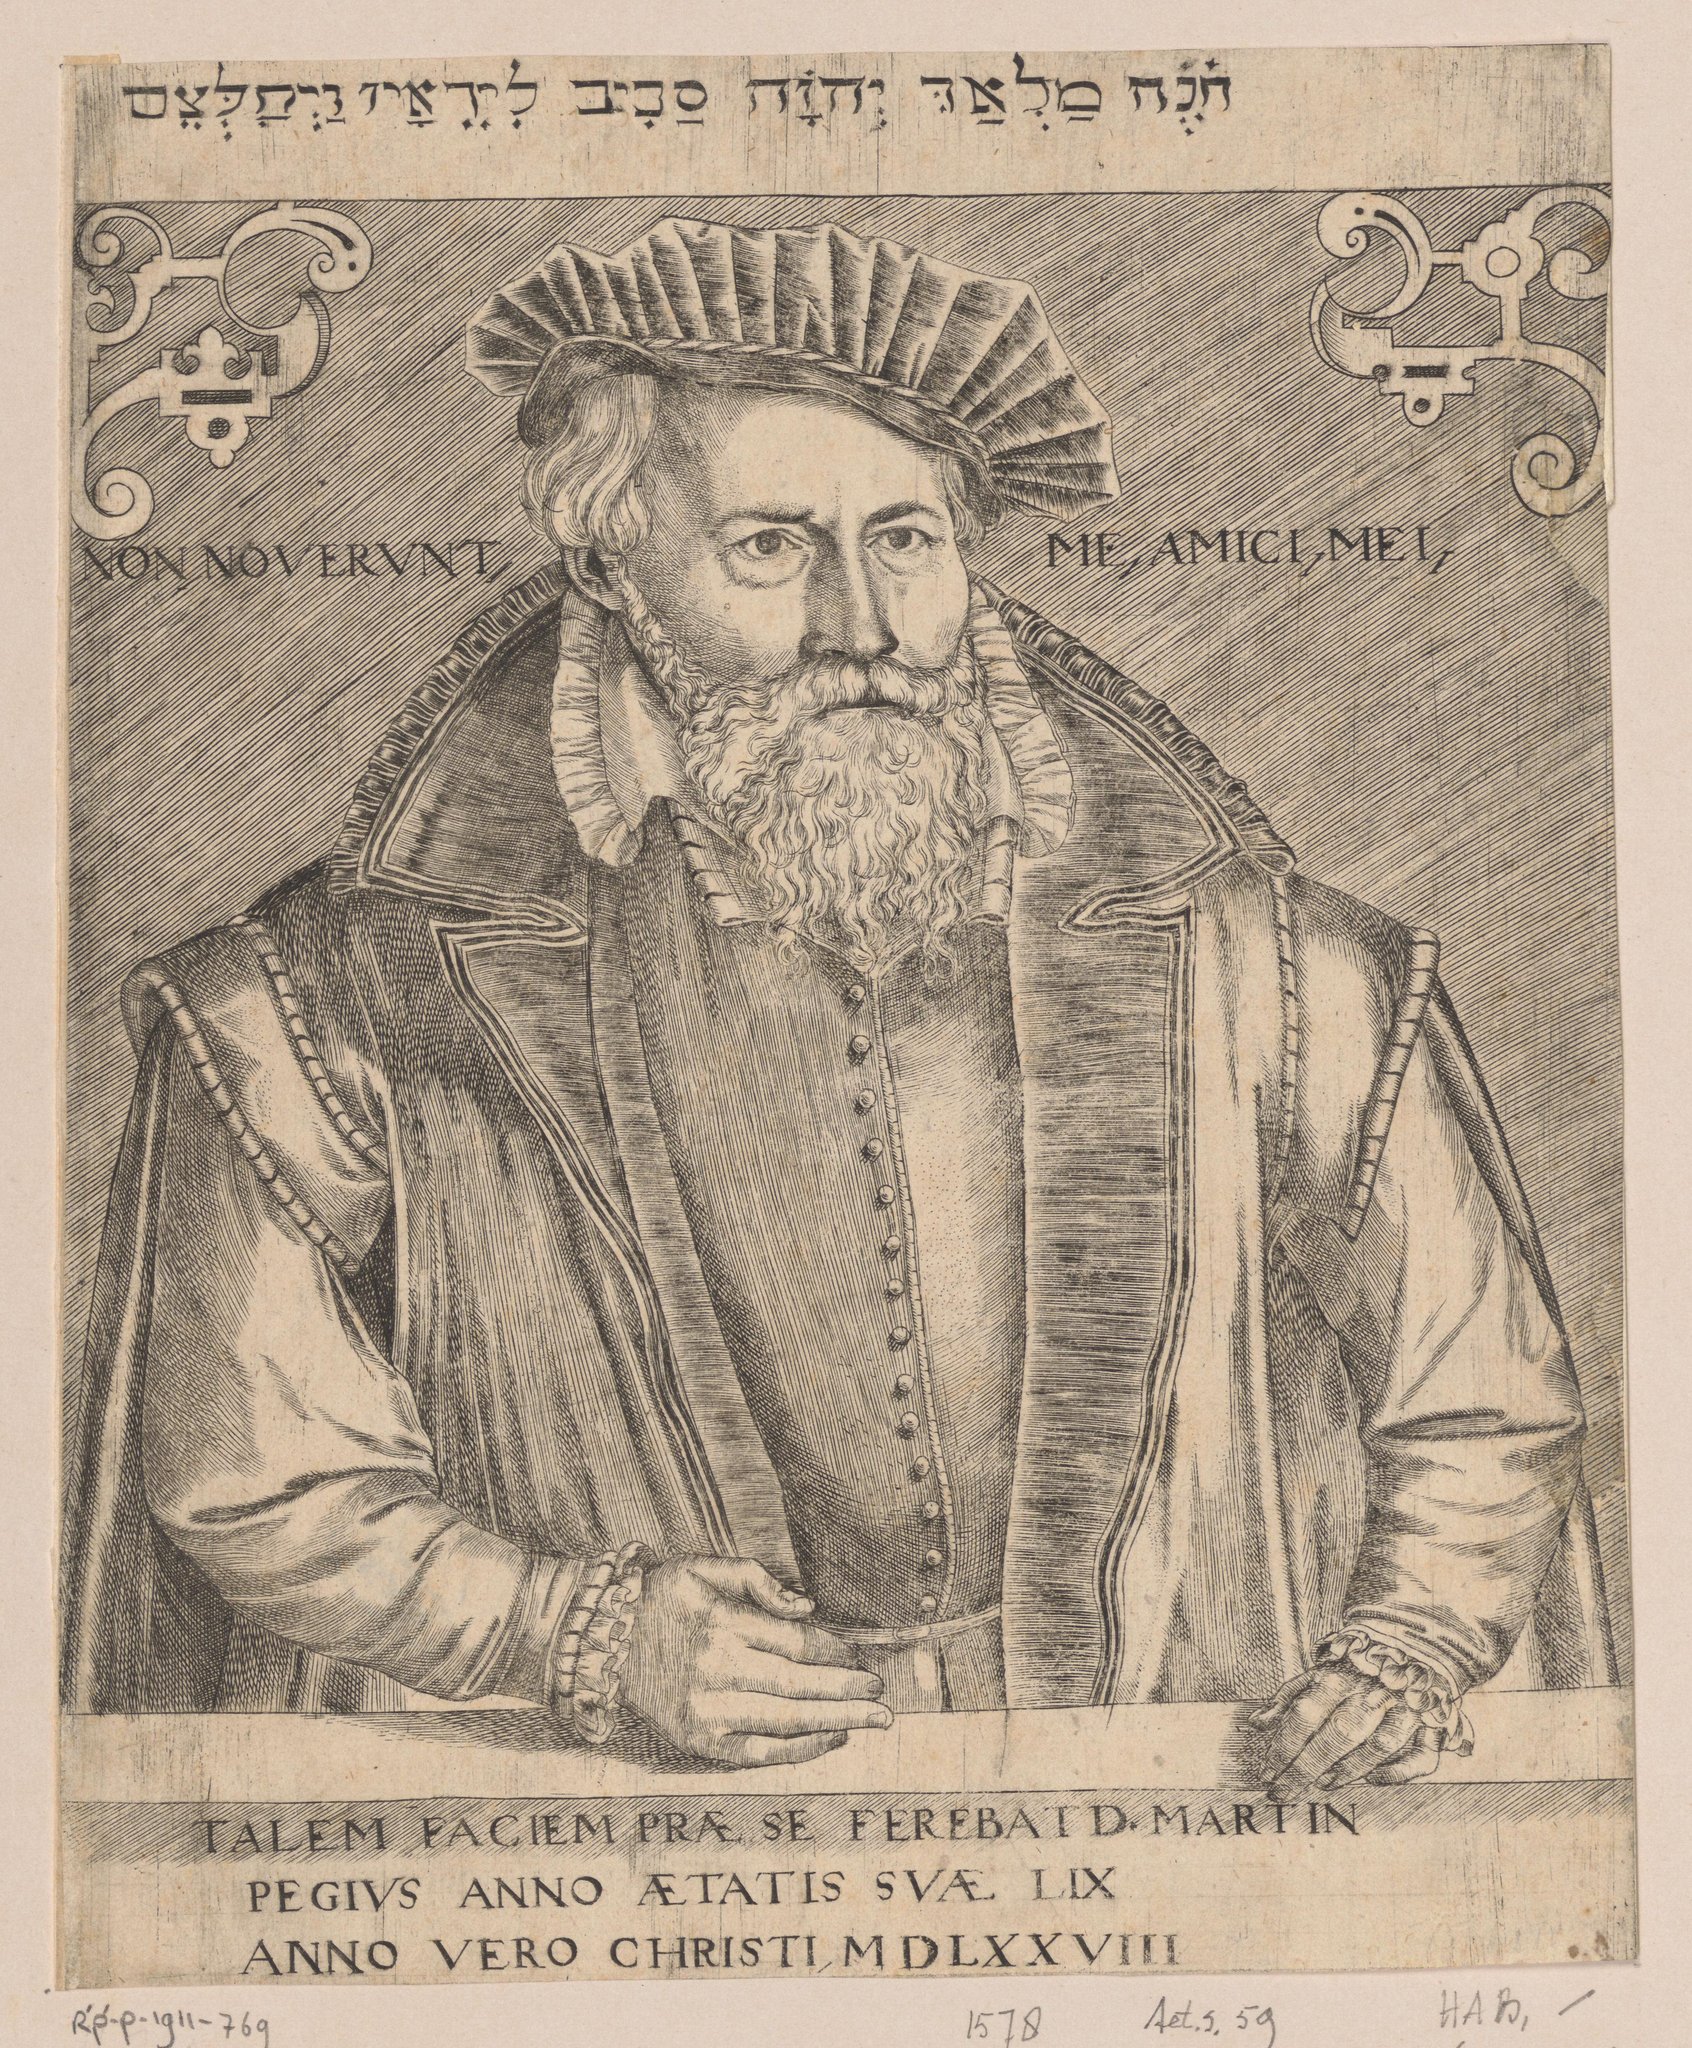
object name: print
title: Portret van Martin Pegius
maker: Anonymous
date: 1578-1699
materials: paper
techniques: engraving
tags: adult man, historical persons